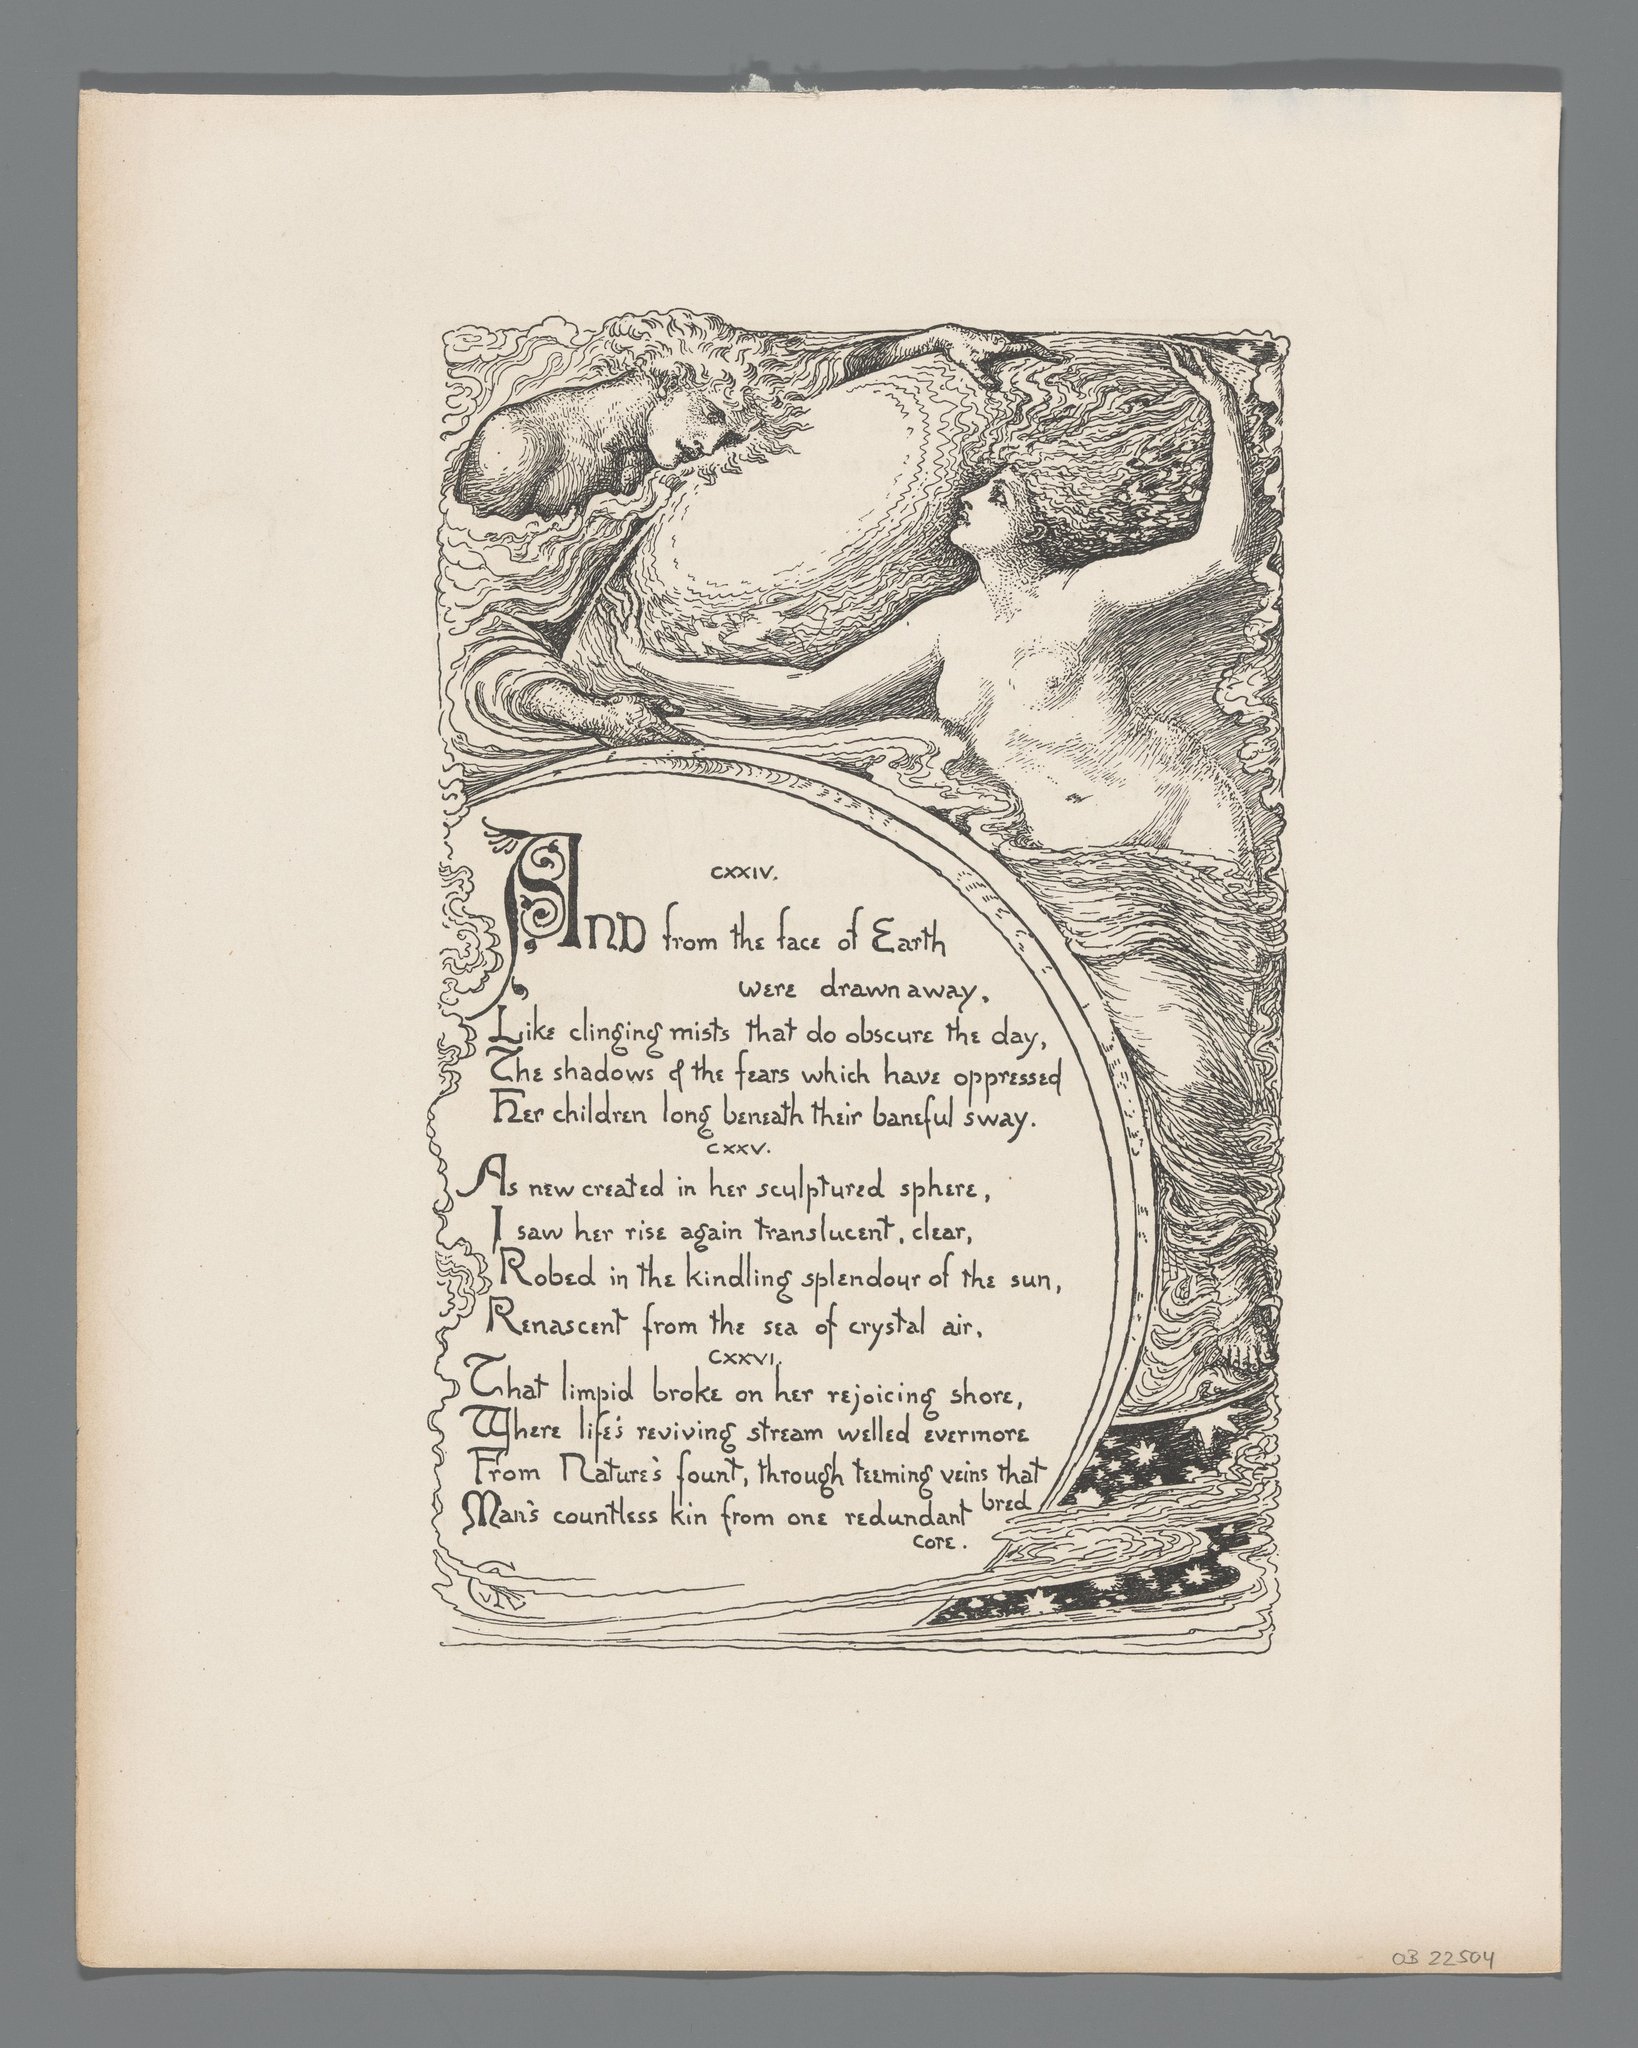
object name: book illustration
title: Cartouche met man en vrouw in het heelal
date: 1886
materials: paper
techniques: engraving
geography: london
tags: adult woman, adult man, stars, the heavens (celestial bodies)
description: Prent uit: Crane, Walter. The sirens three. Londen: Macmillan & Co., 1886.